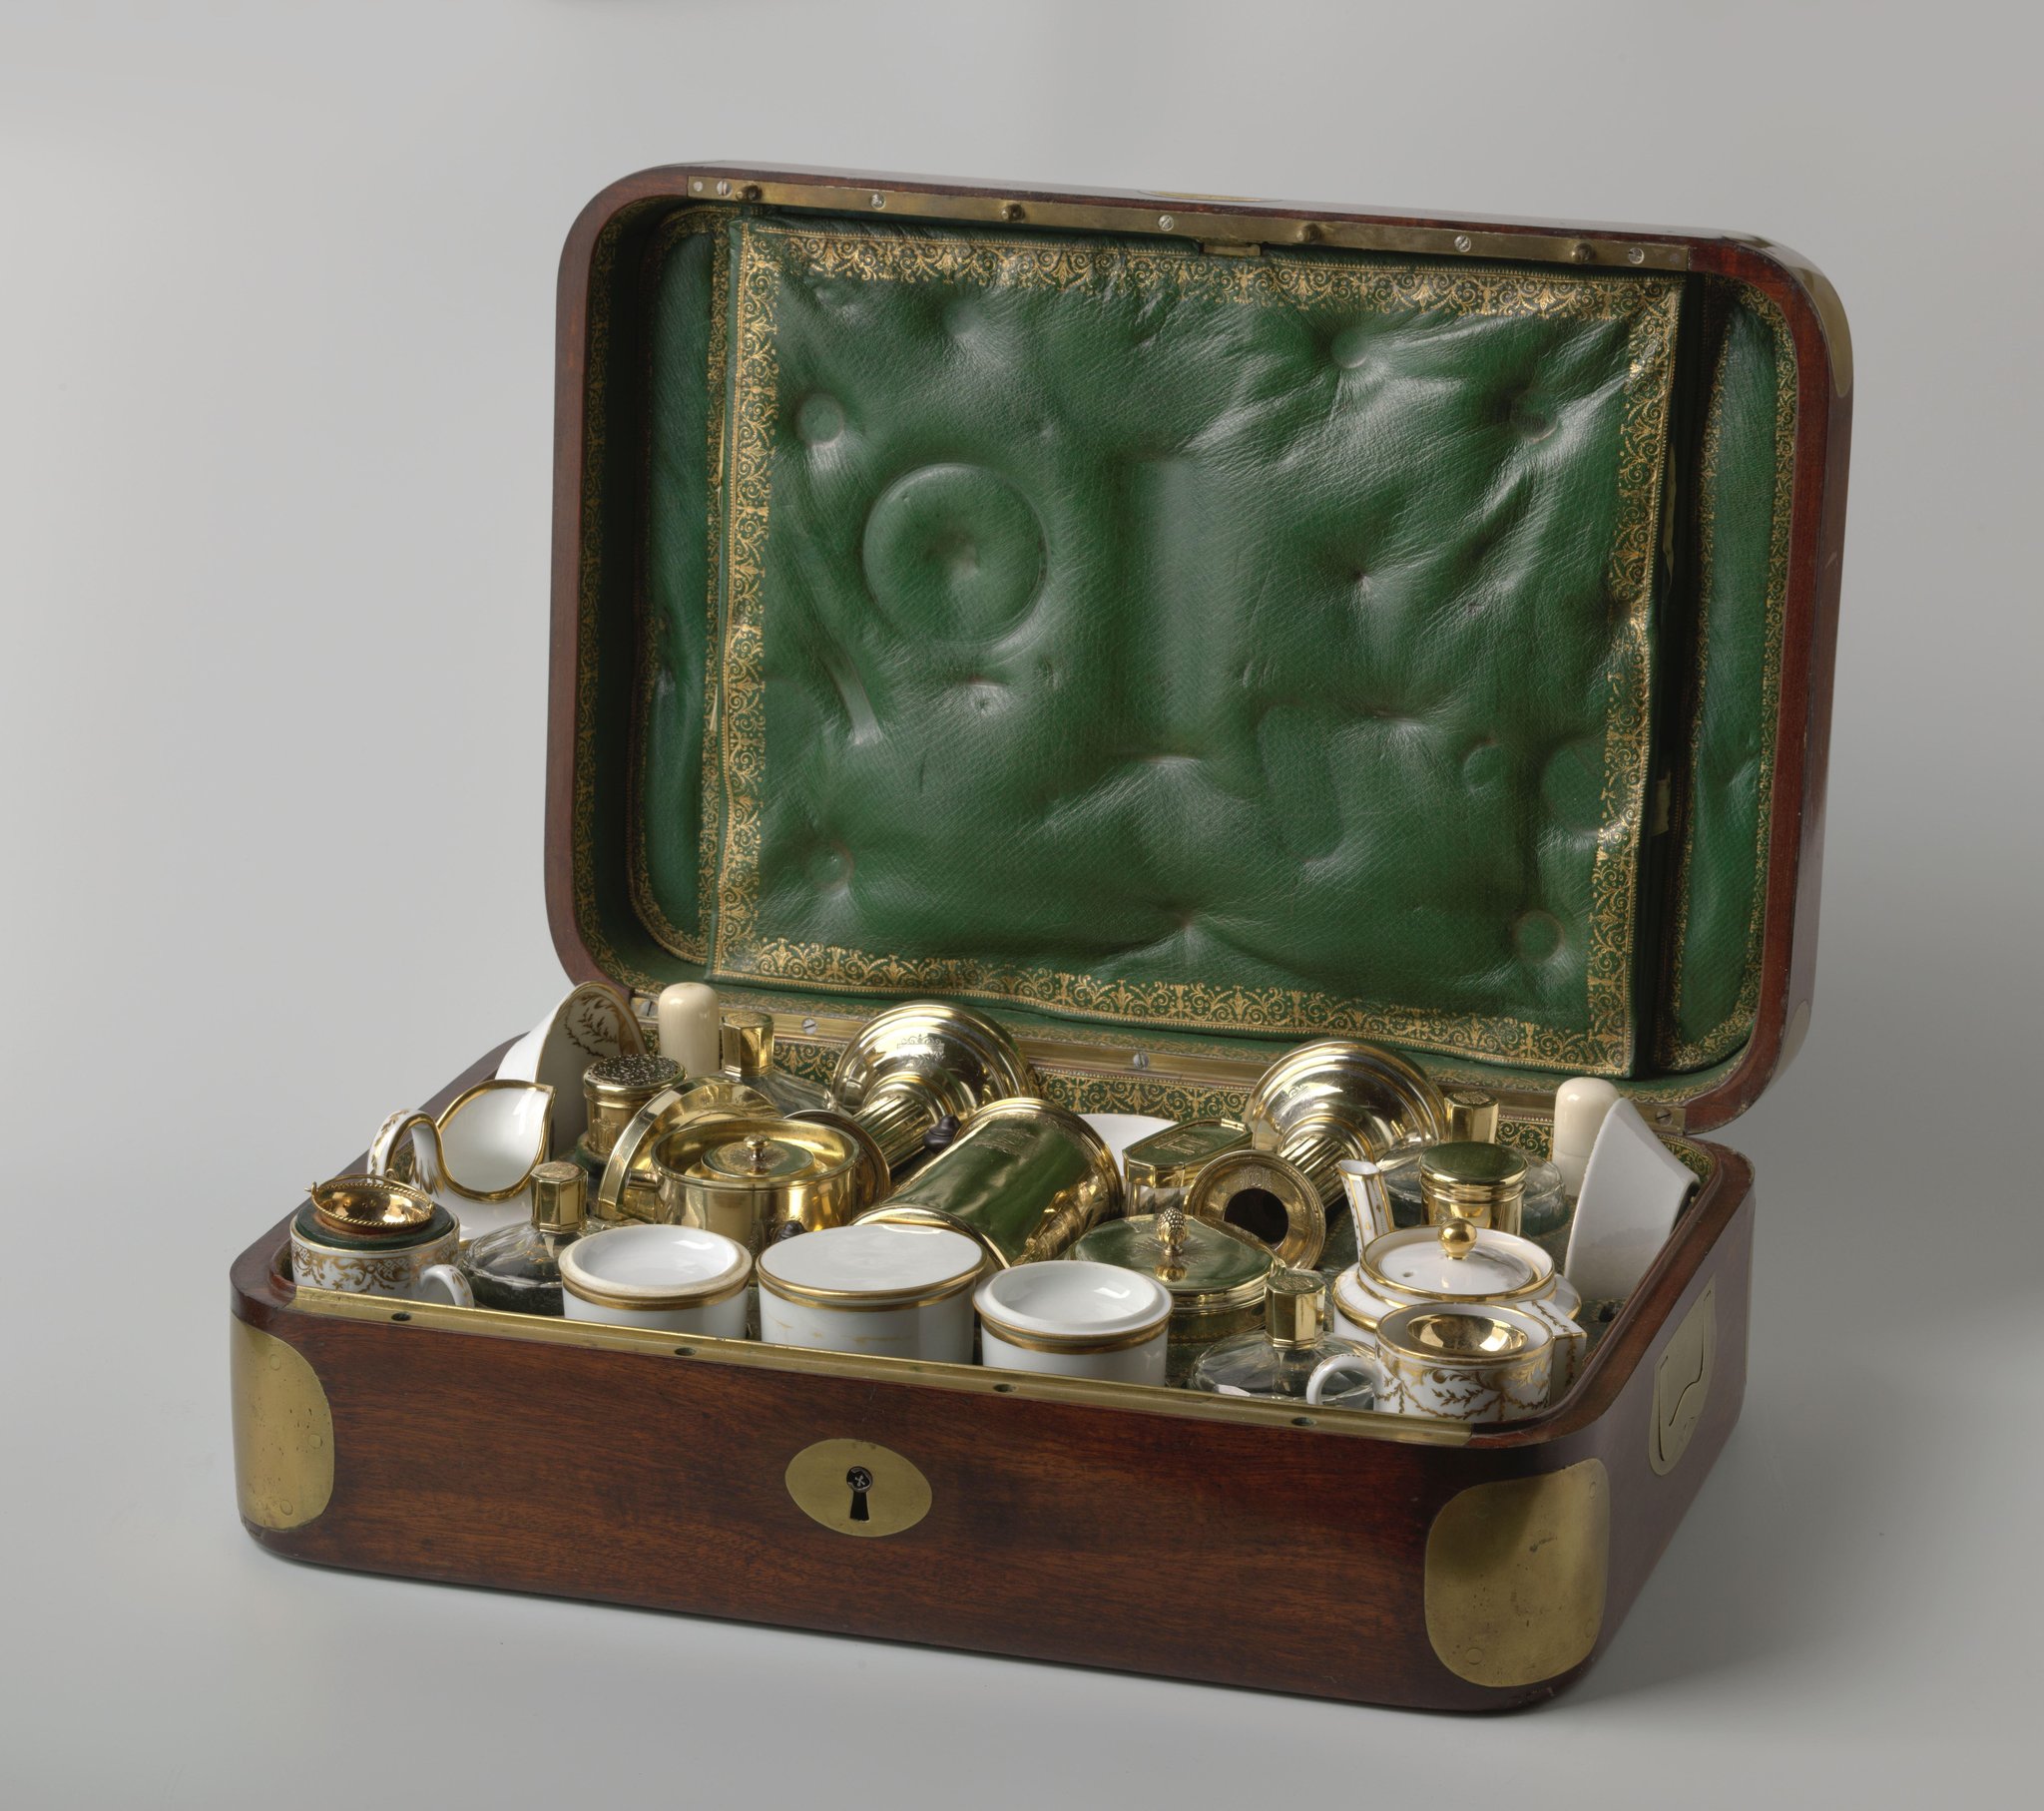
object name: reisnecessaire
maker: roch-louis dany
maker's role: silversmith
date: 1789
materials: leather, wood, porcelain, silver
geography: paris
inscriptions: mark: ‘kreeft 800’, maker's mark: ‘RLD’, import mark: ‘zwaan’, mark: ‘P 89’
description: De kist heeft een groen leren bekleding met vergulde gestanste randen. De deksel heeft een monogram FLC in schild omgeven met ranken. In de deksel ontbreekt het dienblad. De hoeken van de kist zijn van koper, aan beide zijden zijn twee hengsels. De kist heeft een sleutel. Inhoud: een taps toelopend cilindervormige chocolade kan met schroevende ebbenhouten handvat, een schenkkan met deksel met bloemvormige knop met schroevende ebbenhouten handvat met glazen binnenbak in groen leer, twee kandelaars met losse bobeches en een gecanneleerde schacht, een komfoor met schroevend handvat, een trechter, een zandstrooier, een theezeefje, een doosje met kaarshouder, alle verguld zilver met monogram FLC, vier ronde kristallen flacons met verguld zilveren schroevende doppen, een kristallen theeflacon met verguld zilveren schuif sluiting, een ivoren naaldenkoker, een ivoren koker met daarin een spoel, een porseleinen theepot, een suikerbak, een schenkkan, twee kopjes en schoteltjes, drie ronde porseleinen potjes met deksel, de meeste met een grijs geschilderd decor met engeltjes, kinderen, schaap en hond. De meeste zijn gesigneerd met Manufacture de Monseigneur Le Duc d’Angoulème à Paris.